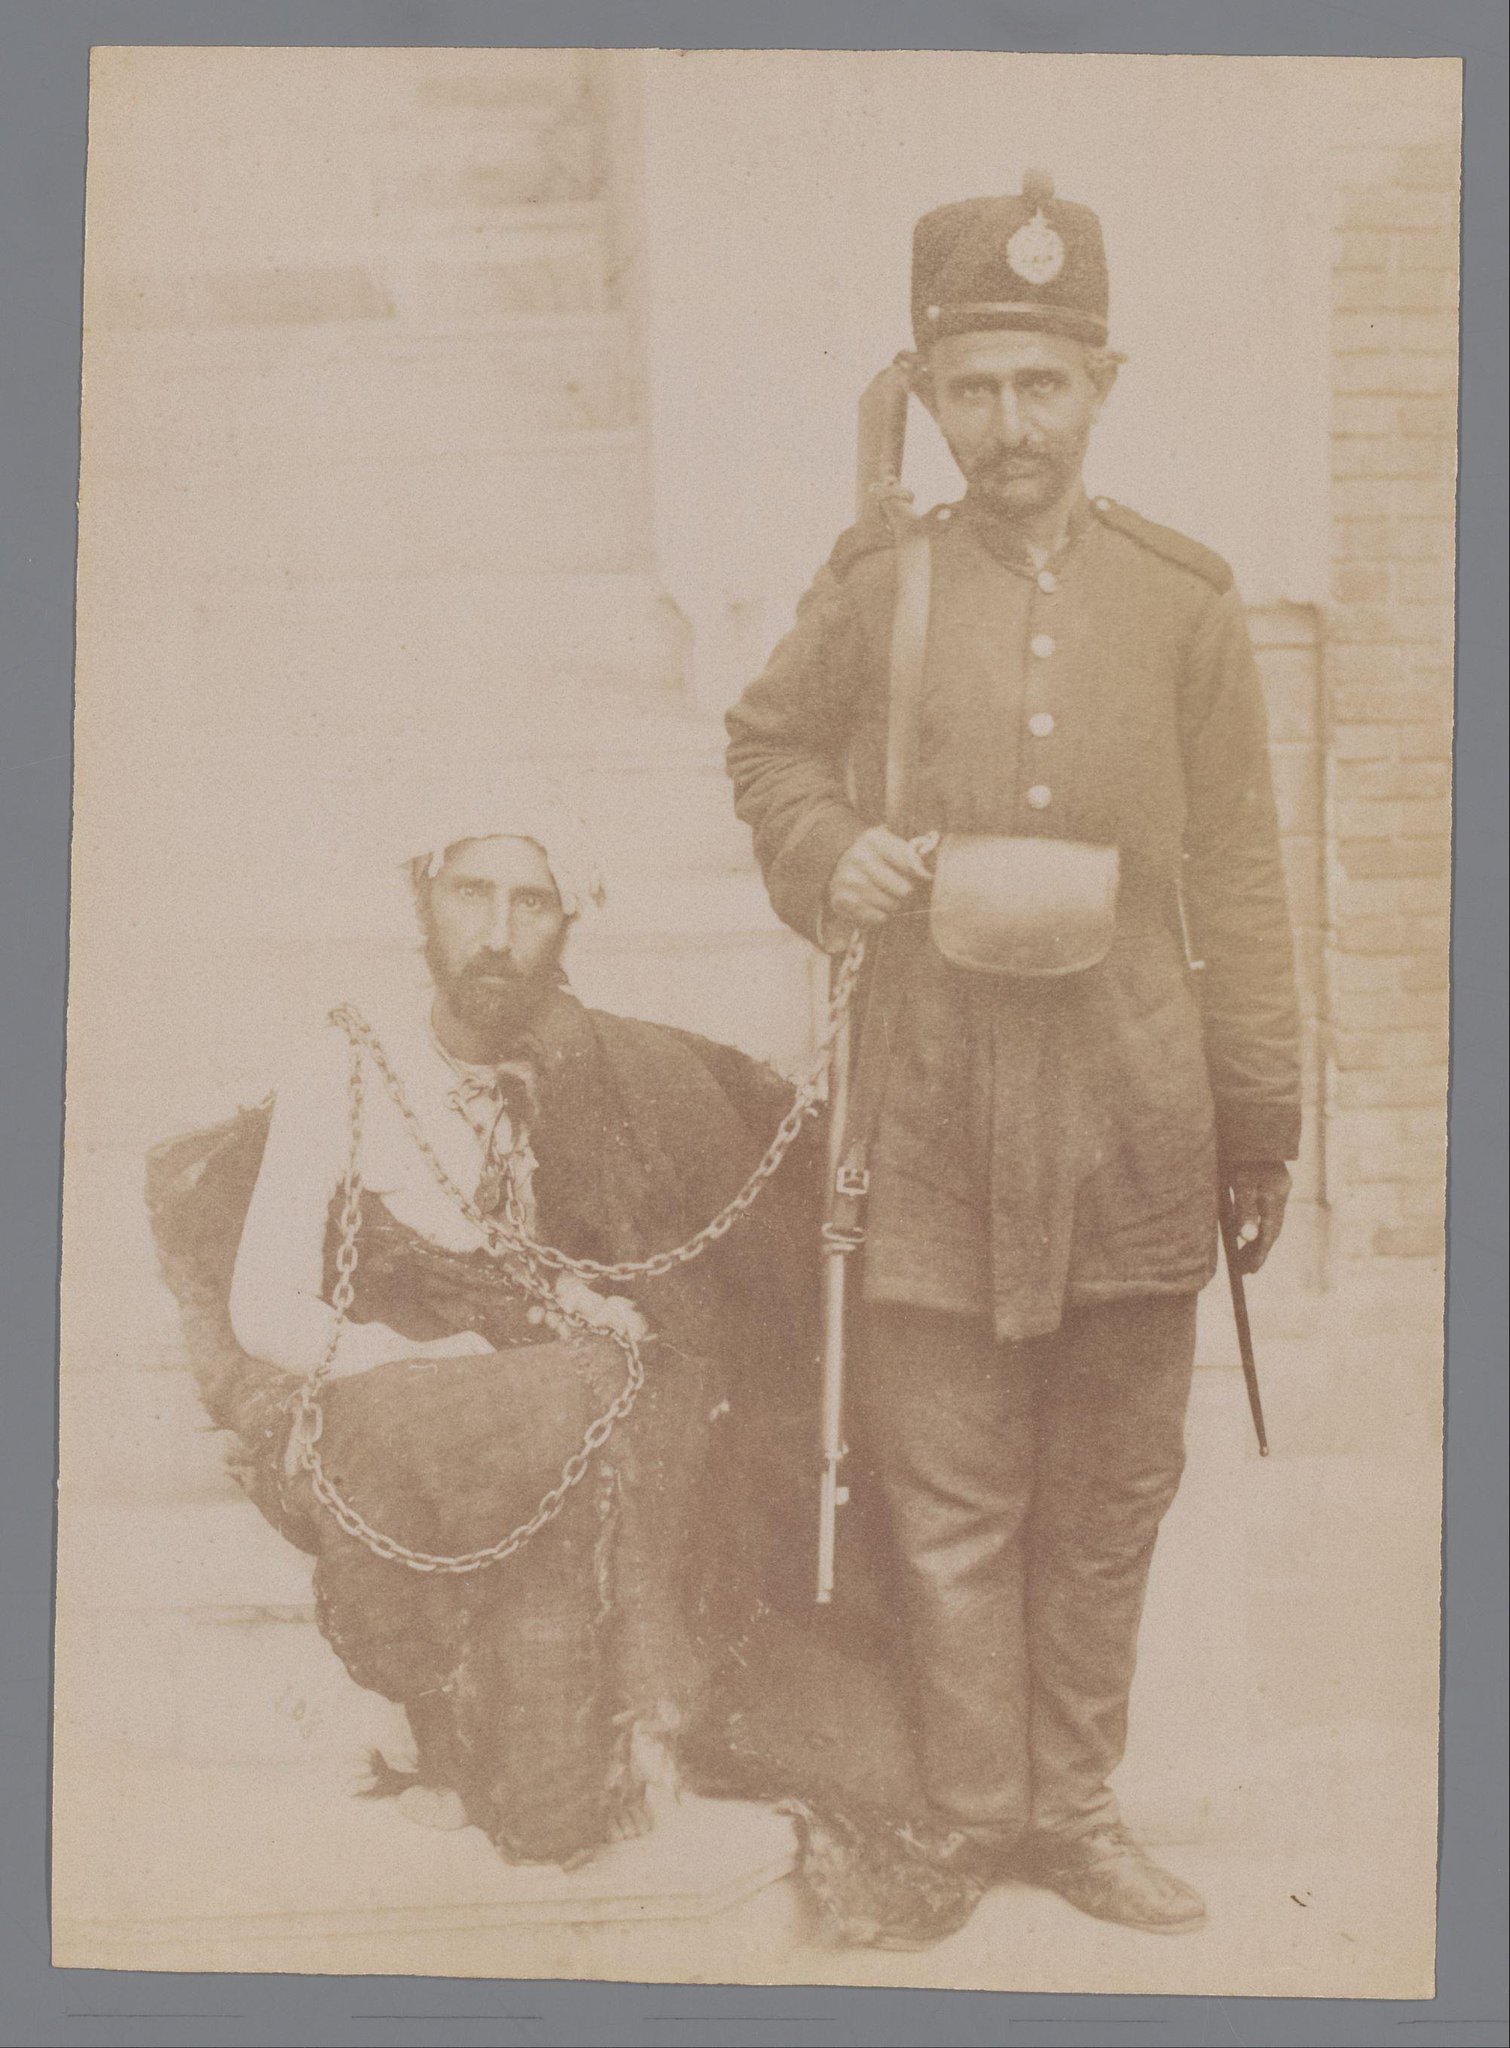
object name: photograph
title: Portret van twee mannen: een gevangene en een bewaker, Iran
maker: antoine sevruguin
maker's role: fotograaf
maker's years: 1840-1933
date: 1885-1910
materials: paper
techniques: albumen print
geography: iran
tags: iran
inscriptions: number: ‘208’, inscription: ‘Rizei [?]’, number: ‘2.’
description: Frontaal portret van twee mannen: een gevangene en een bewaker. De gevangene is geketend met een lange ketting en hurkt wezenloos starend en gewikkeld in een deken op de grond. De bewaker in uniform staat en heeft de ketting in zijn hand, een geweer om de schouder.